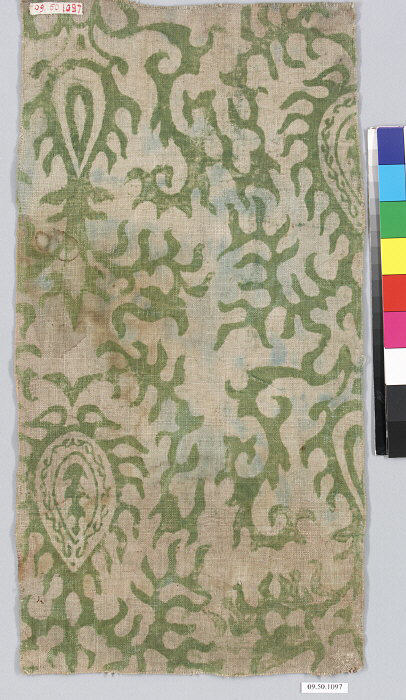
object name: fragment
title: Fragment of reproduction of 15-16th century design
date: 1801-1900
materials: linen